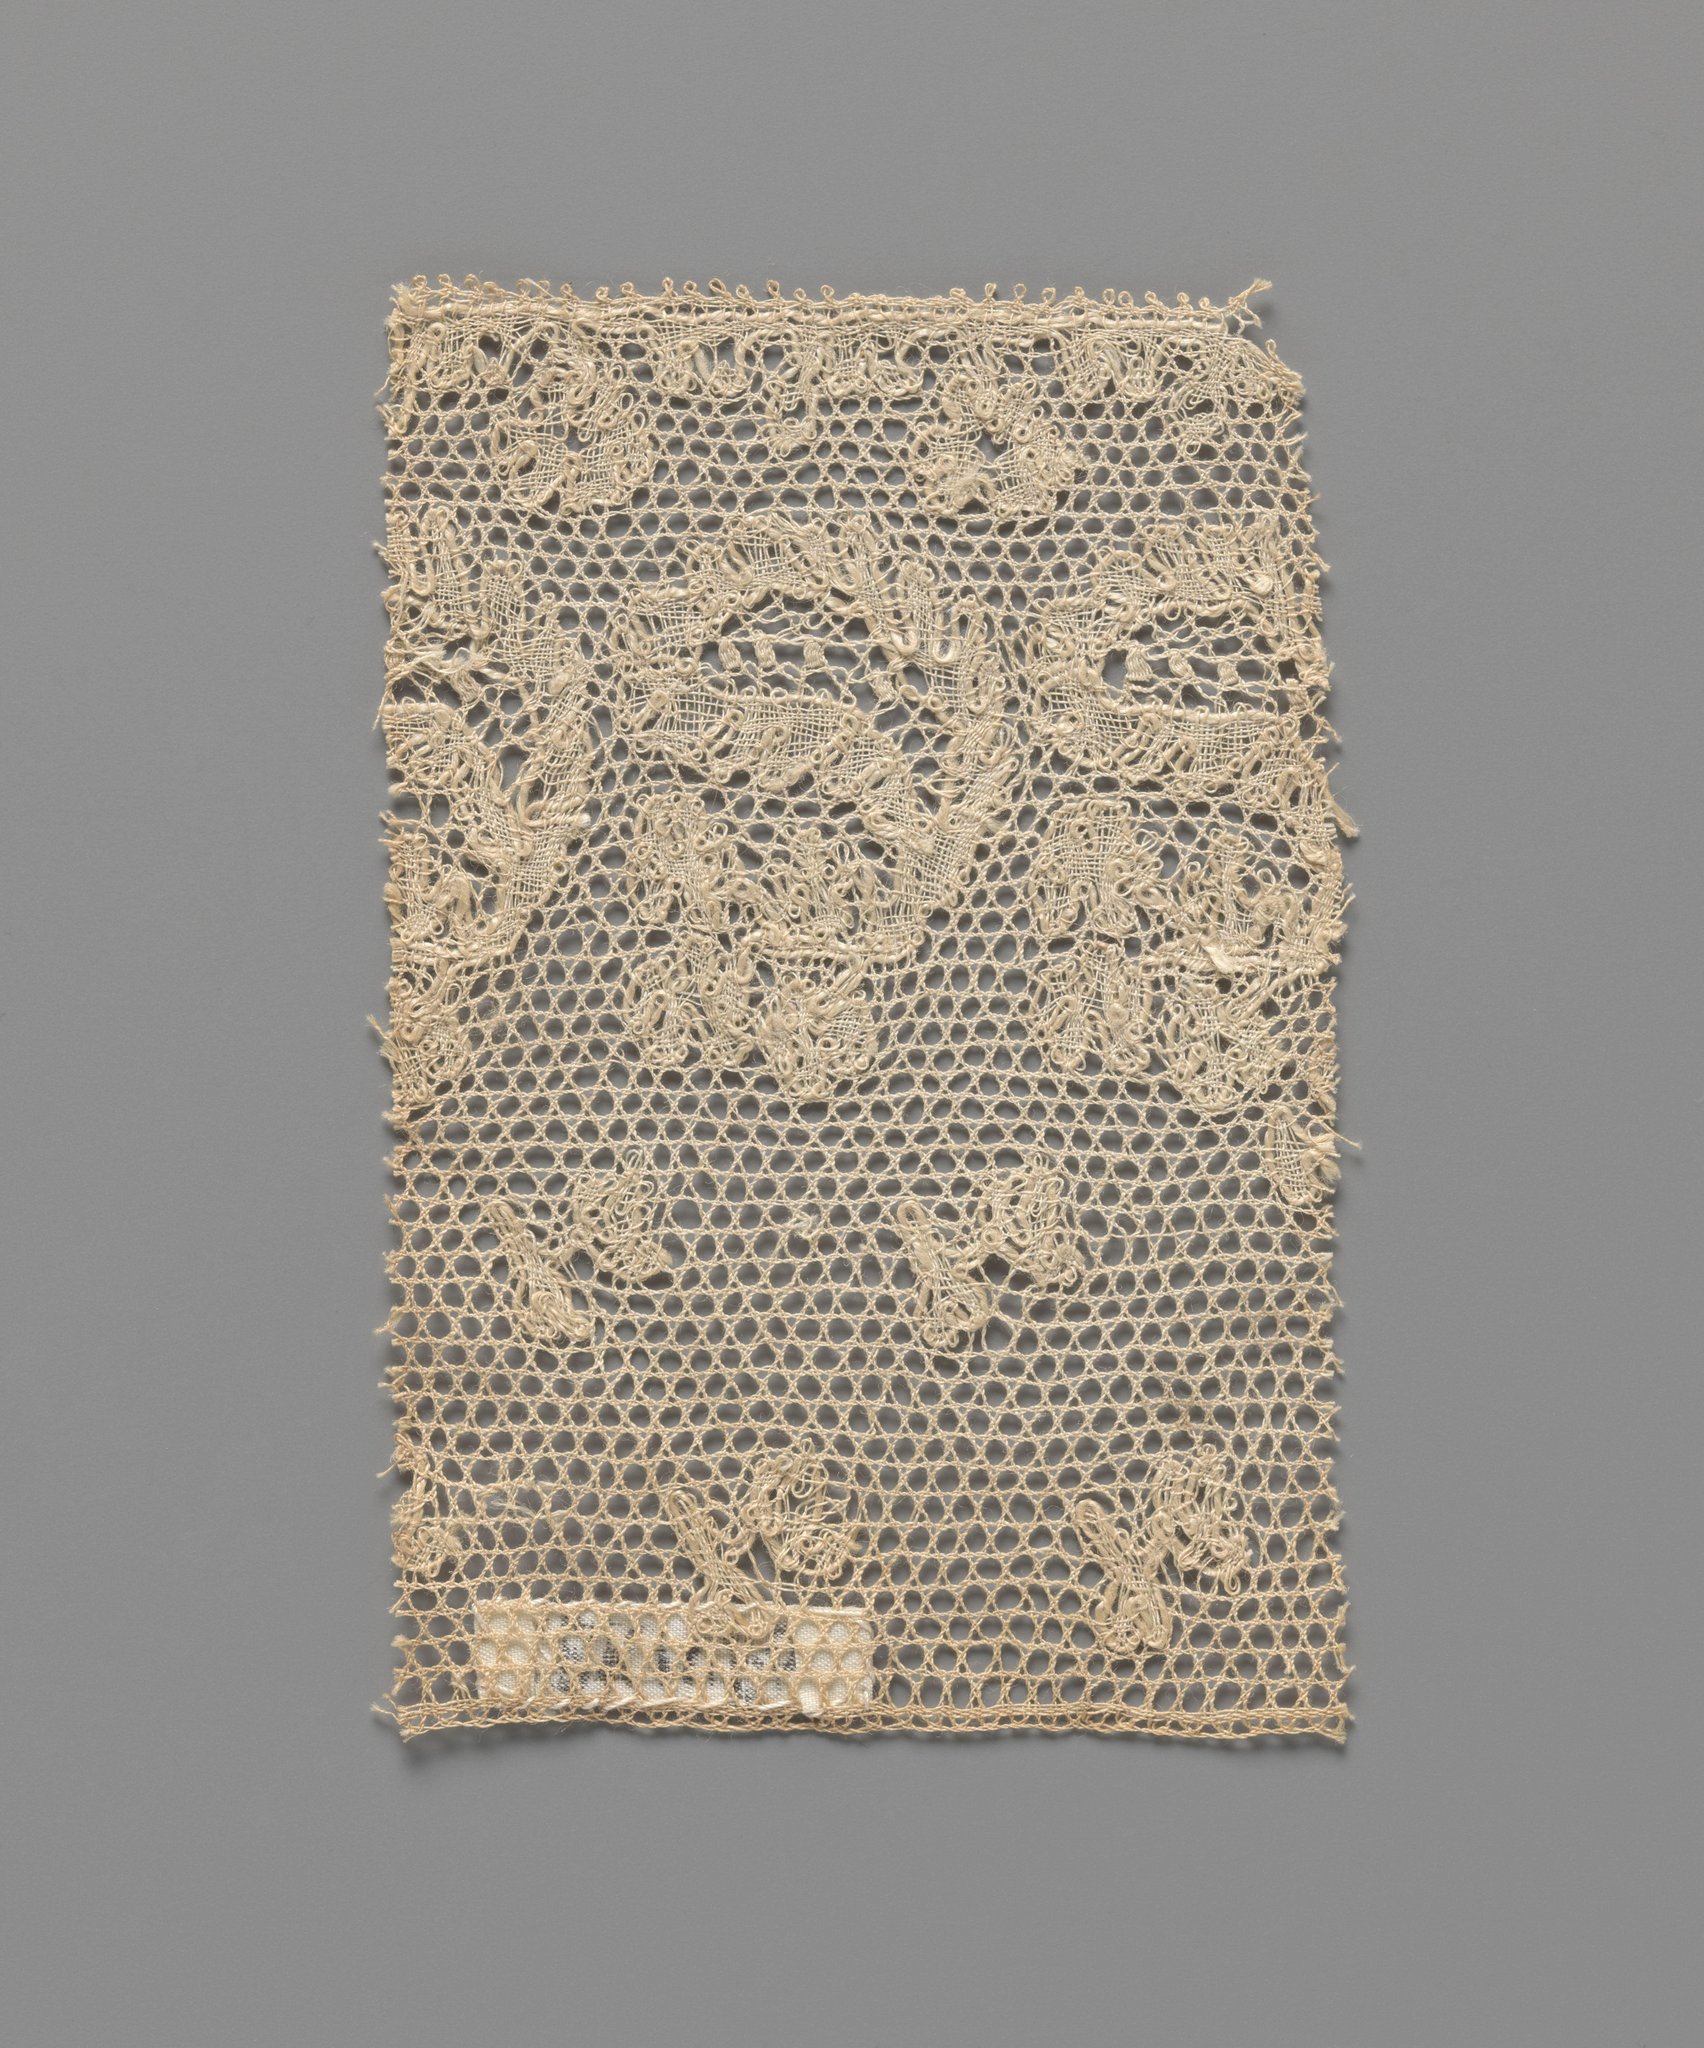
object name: sample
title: Staal kloskant met Parijse grond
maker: Anonymous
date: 1875-1899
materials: cotton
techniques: lace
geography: turnhout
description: Staal naturelkleurige kloskant: Parijse kant. Afkomstig van een opgeheven kantschool te Turnhout.